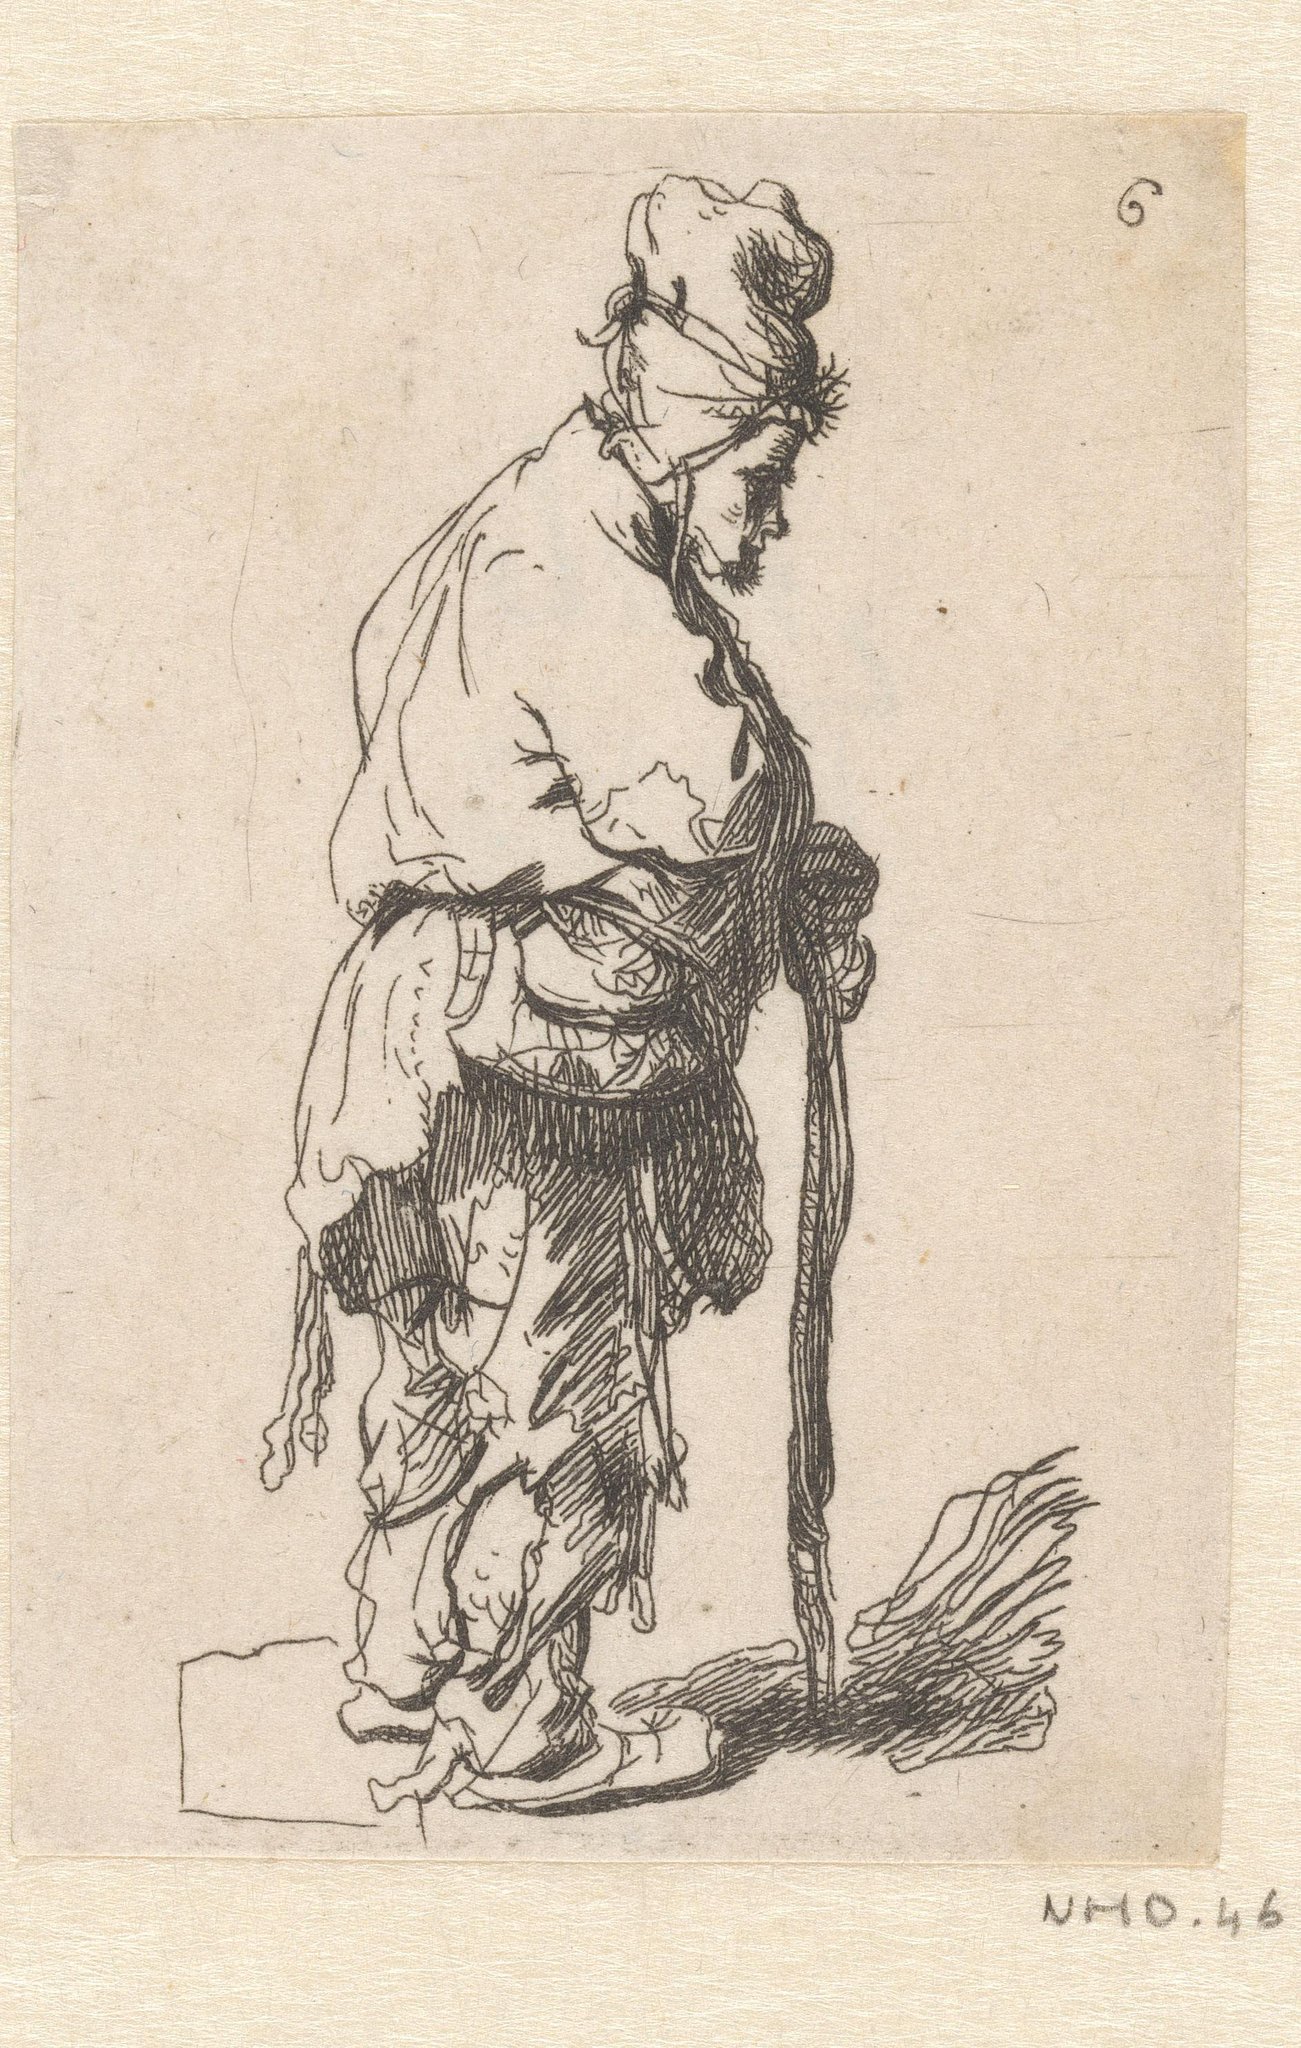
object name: print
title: Beggar leaning on a stick, facing left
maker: françois vivares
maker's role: print maker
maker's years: 1709-1780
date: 1719-1780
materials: paper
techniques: etching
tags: beggar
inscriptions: collector's mark: Lugt 2228, collector's mark: Lugt 2760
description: Spiegelbeeldige kopie naar de gelijknamige prent van Rembrandt. Prent gebruikt in: A collection of 200 original etchings. Londen: J.M. Creery, [1816].